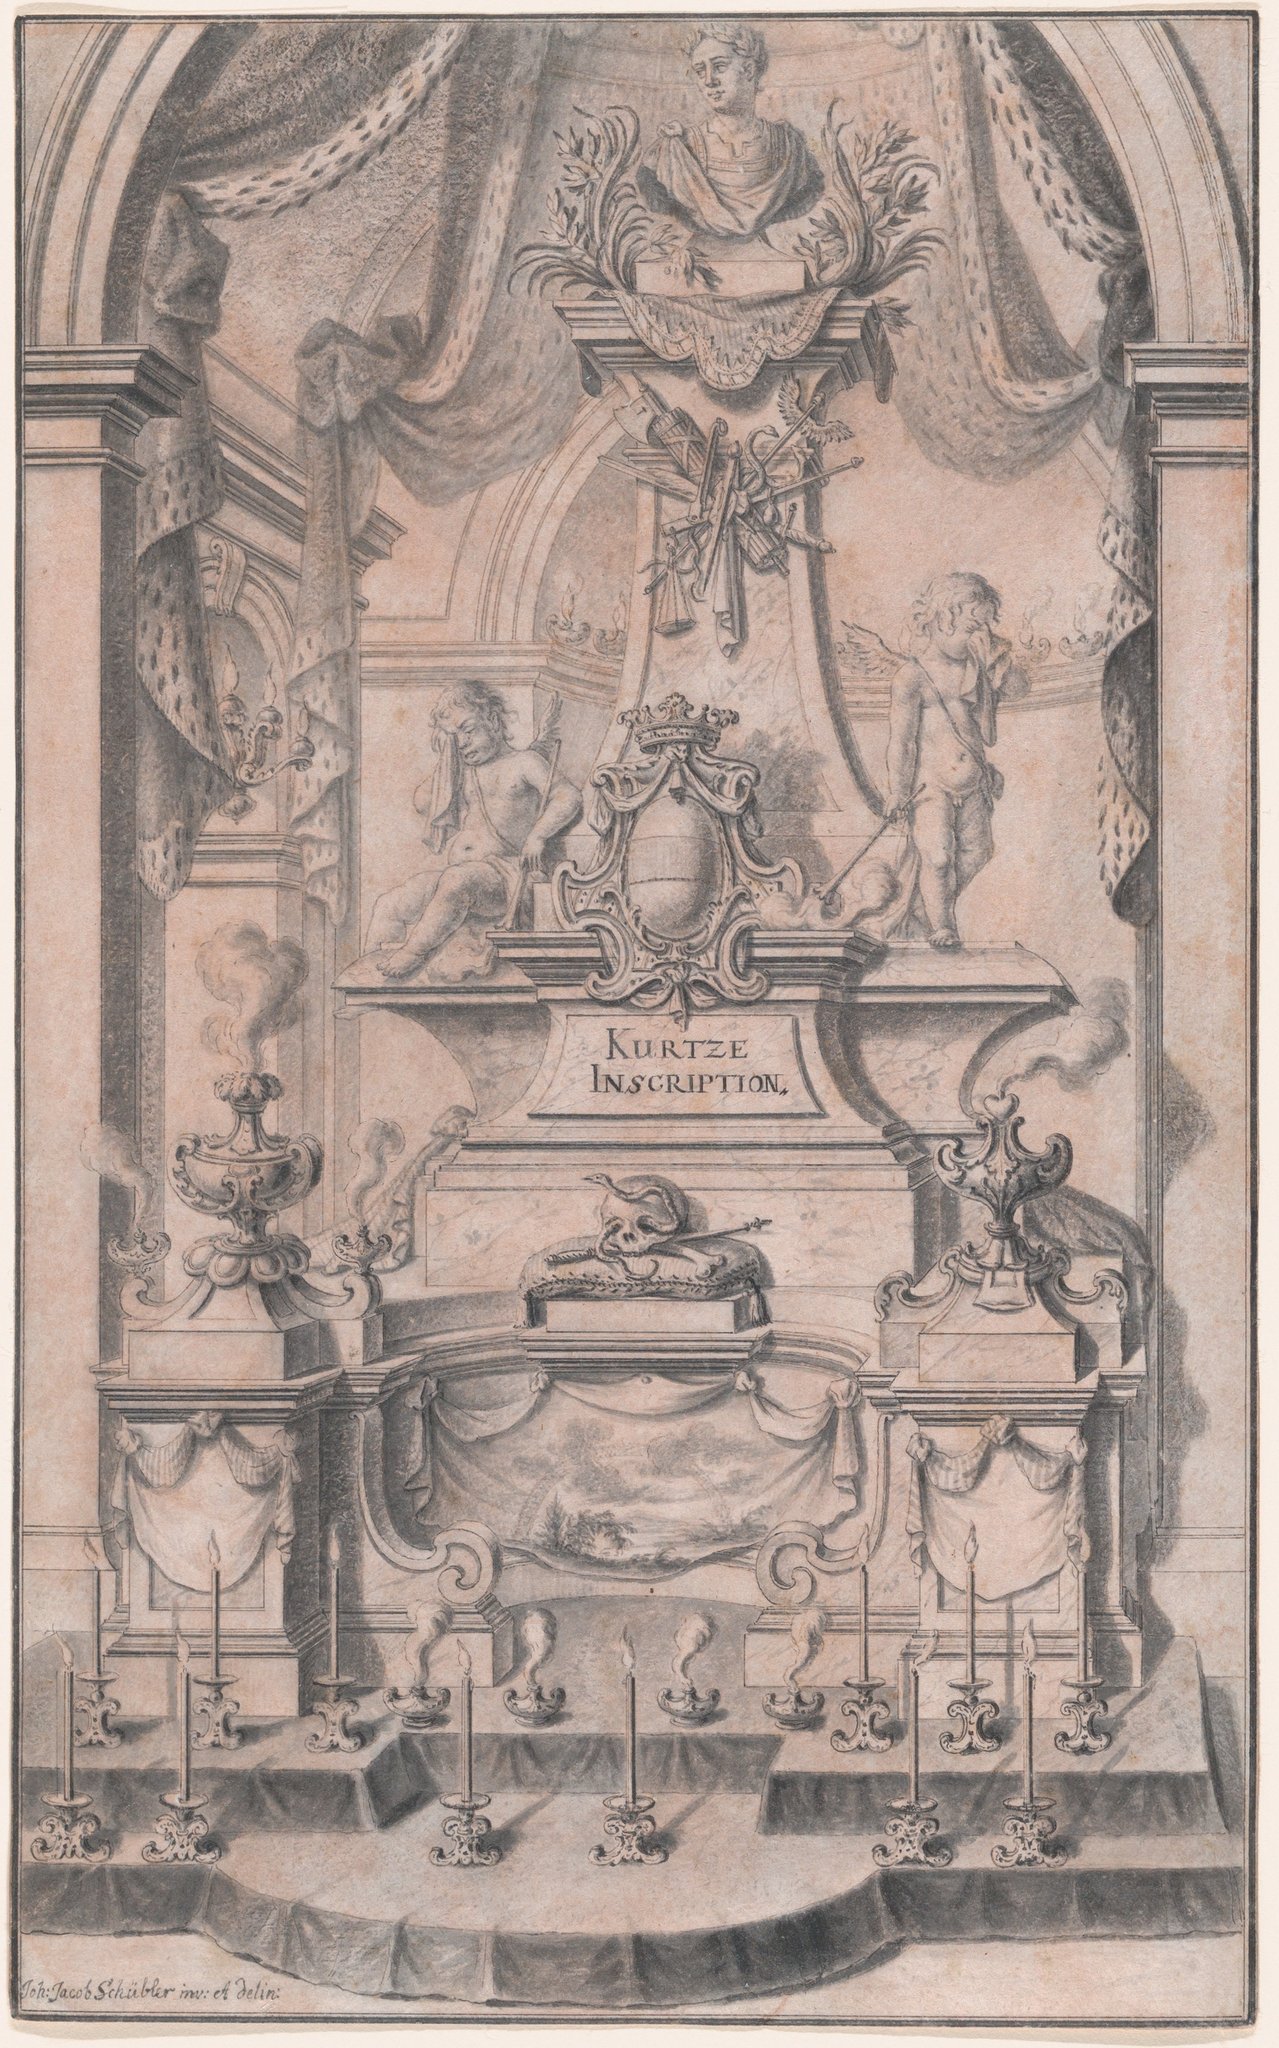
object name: drawing ornament architecture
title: Design for a Funeral Monument (Preparatory Drawing for a Print)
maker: johann jakob schübler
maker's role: artist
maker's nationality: german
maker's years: 1689-1741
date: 1724-1741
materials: ink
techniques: pen, wash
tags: monuments,men,coat of arms